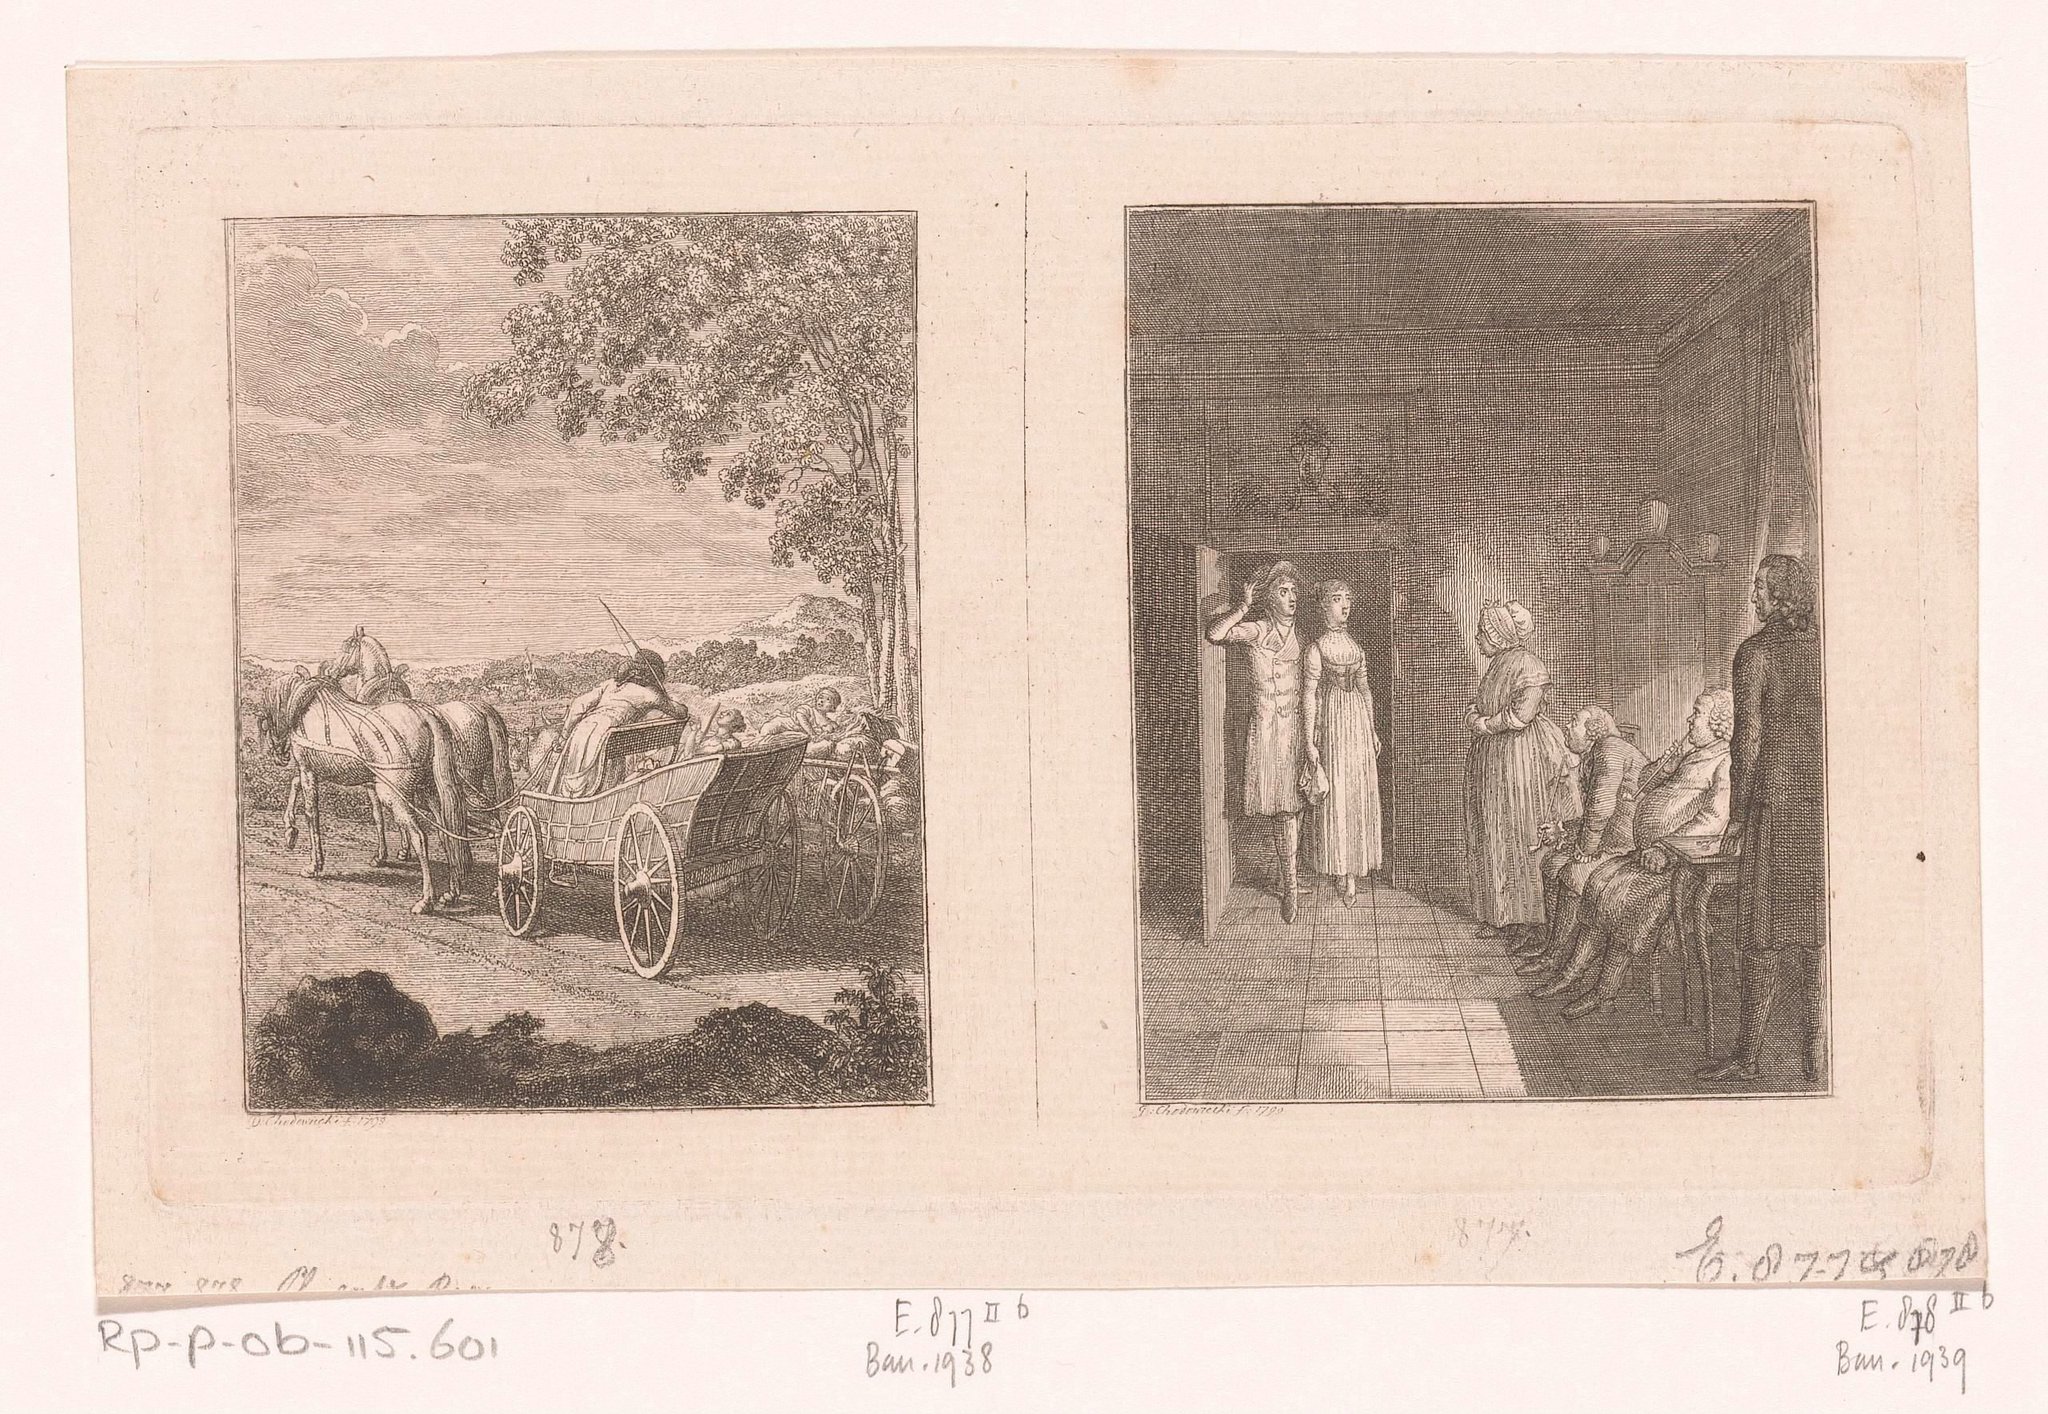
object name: print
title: Twee voorstellingen uit Hermann und Dorothea van Johann Wolfgang von Goethe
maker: daniel nikolaus chodowiecki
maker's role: draughtsman, print maker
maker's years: 1726-1801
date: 1798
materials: paper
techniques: etching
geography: berlin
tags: introducing, emigration, four-wheeled, animal-drawn vehicle, e.g.: cab, carriage, coach, the new-born child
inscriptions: collector's mark: Lugt 2228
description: Vervaardigd voor Hermann und Dorothea van Johann Wolfgang von Goethe. Prent gebruikt voor: Neuffer, Christian Ludwig. Taschenbuch für Frauenzimmer von Bildung, auf das Jahr 1799 und 1800. Stuttgart: Steinkopf, s.a.